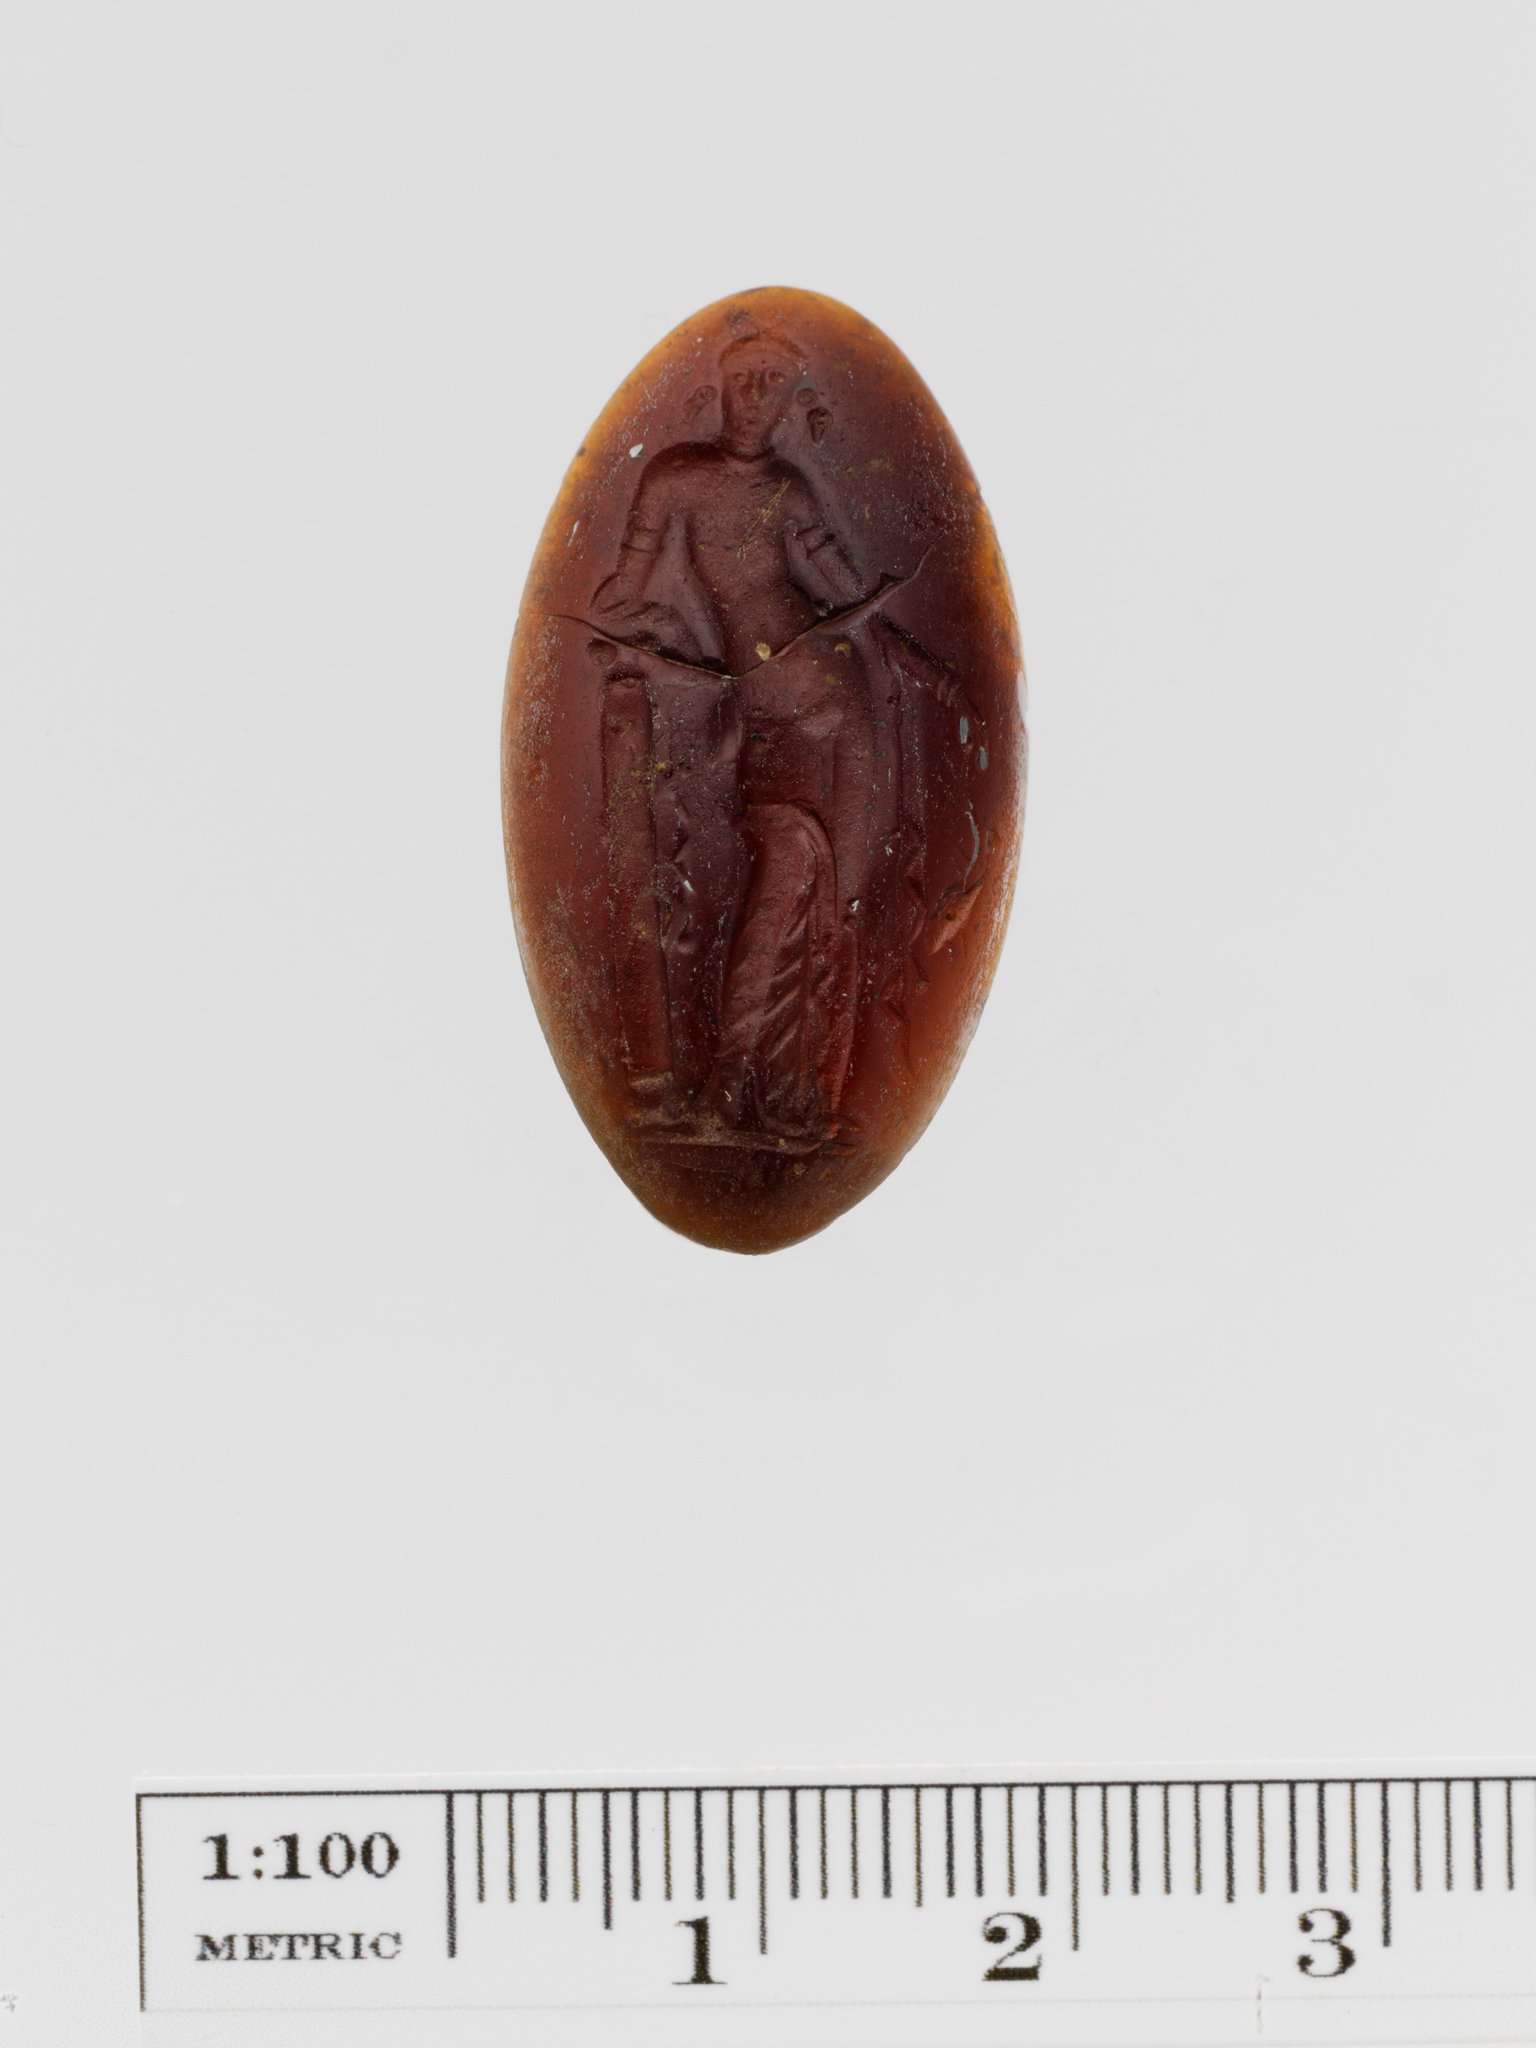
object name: intaglio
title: Glass ring stone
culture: greek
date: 300-101 BCE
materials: glass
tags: columns,aphrodite